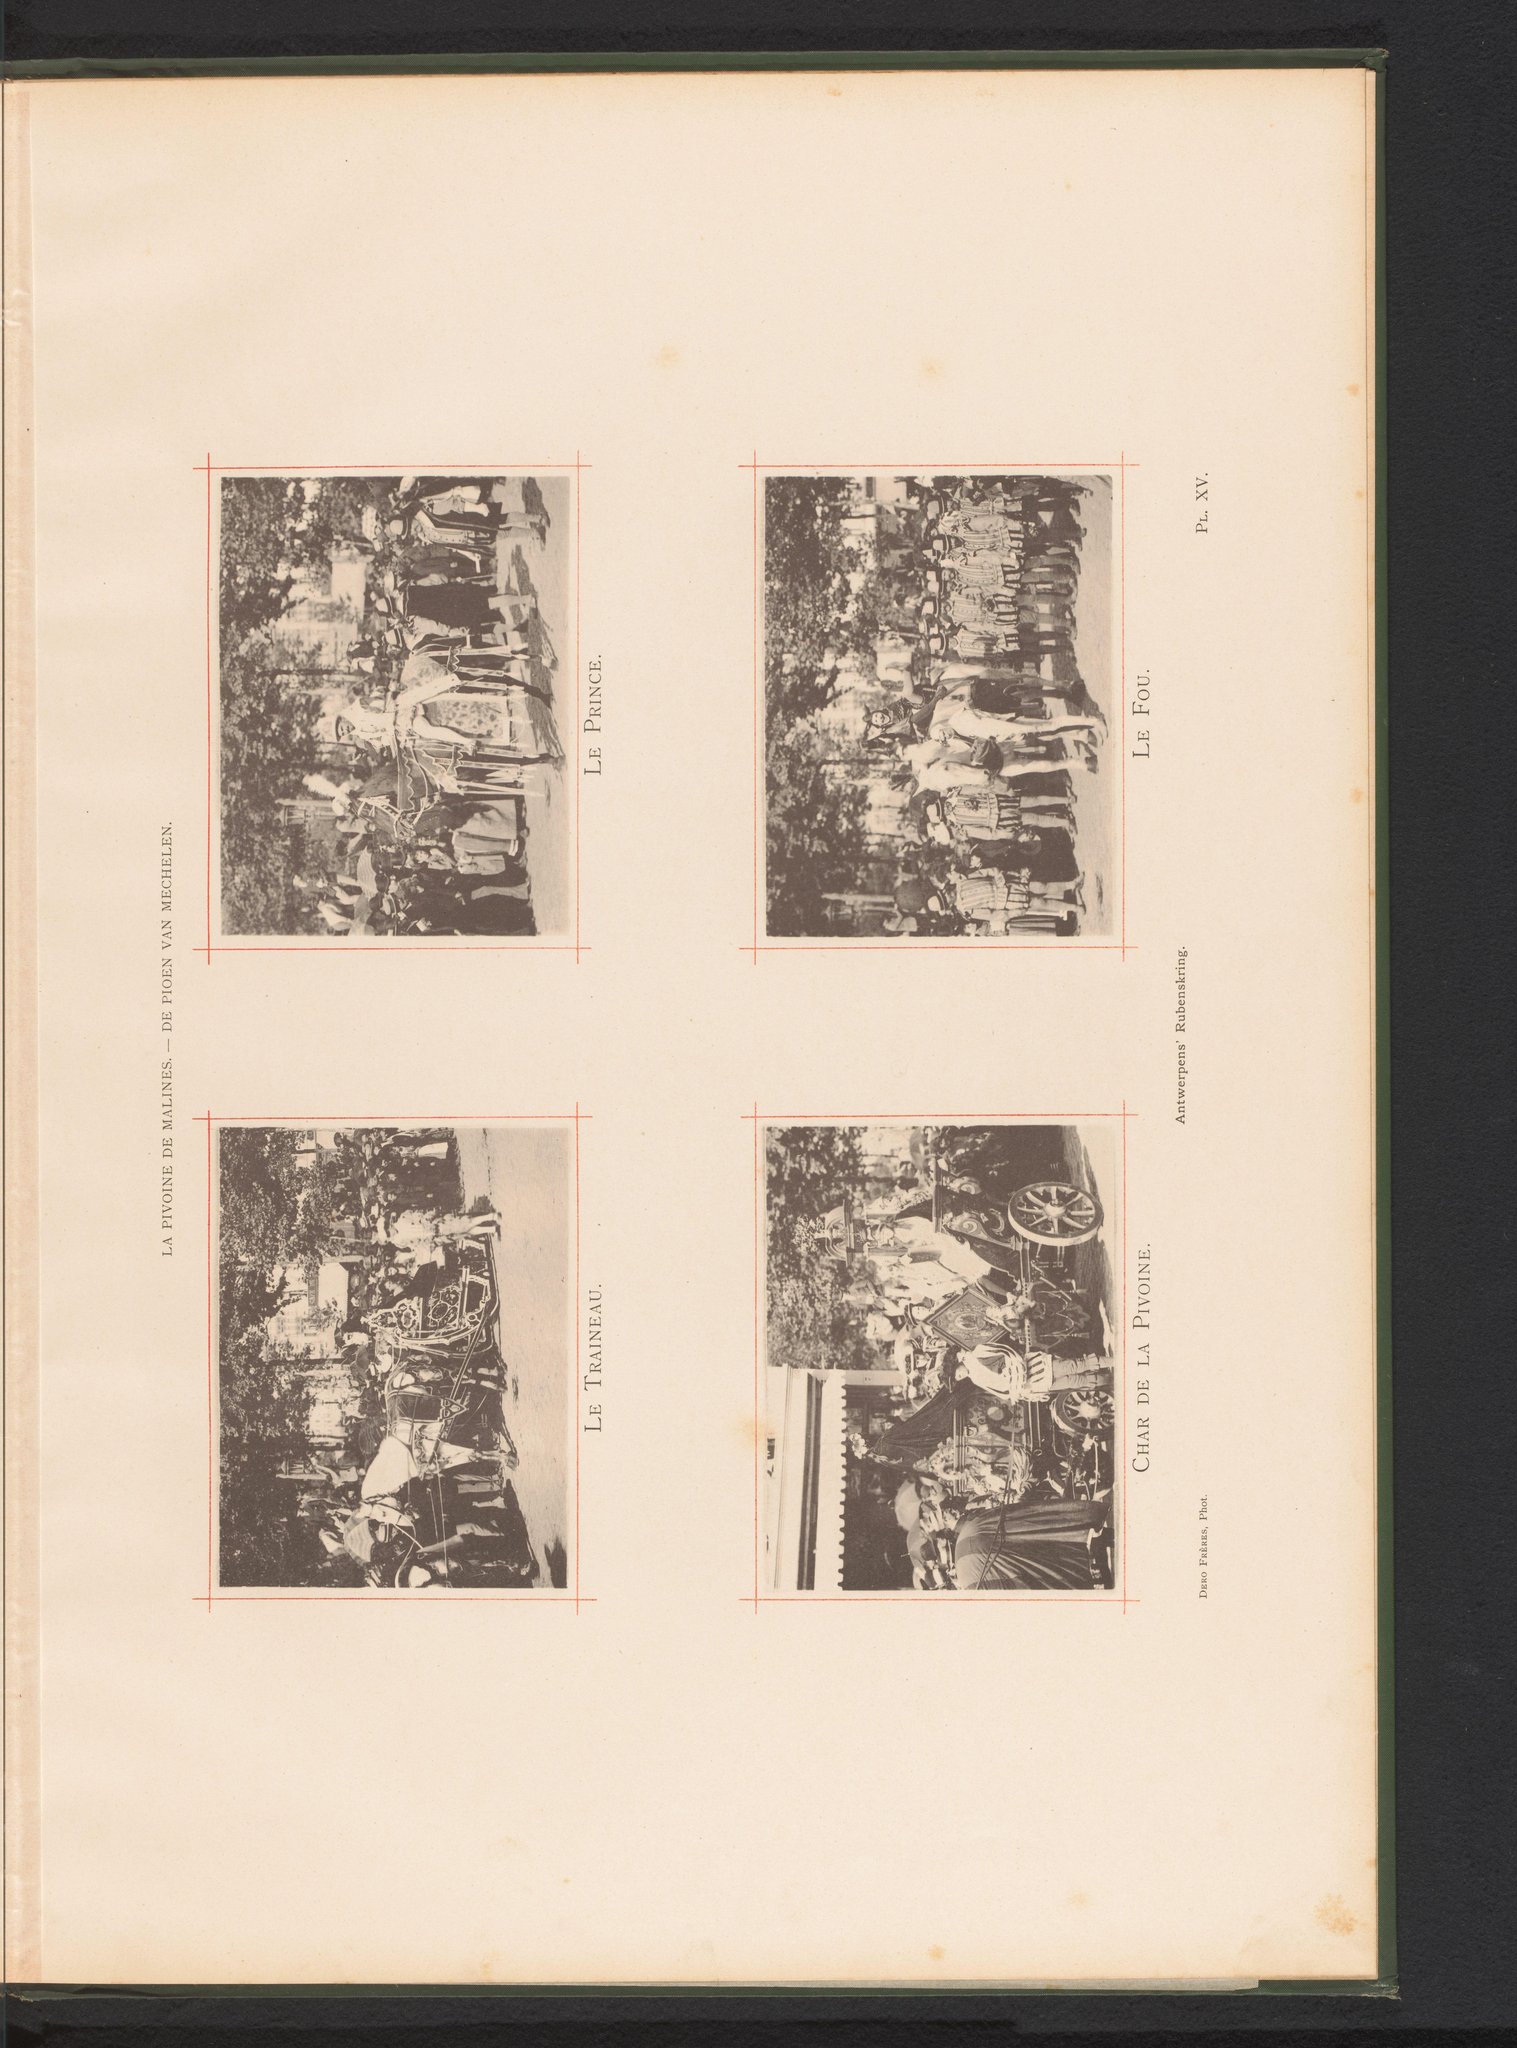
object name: page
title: Char de la Pivoine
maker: joseph maes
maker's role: fotograaf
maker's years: 1838-1908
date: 1892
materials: paper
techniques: photograph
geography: antwerp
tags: public festivities (+ parade, pageant, cavalcade ~ festive activities), antwerp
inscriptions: inscription: ‘LA PIVOINE DE MALINES. - DE PIOEN VAN MECHELEN.’, number: ‘Pl. XV.’, inscription: ‘Antwerpens' Rubenskring.’